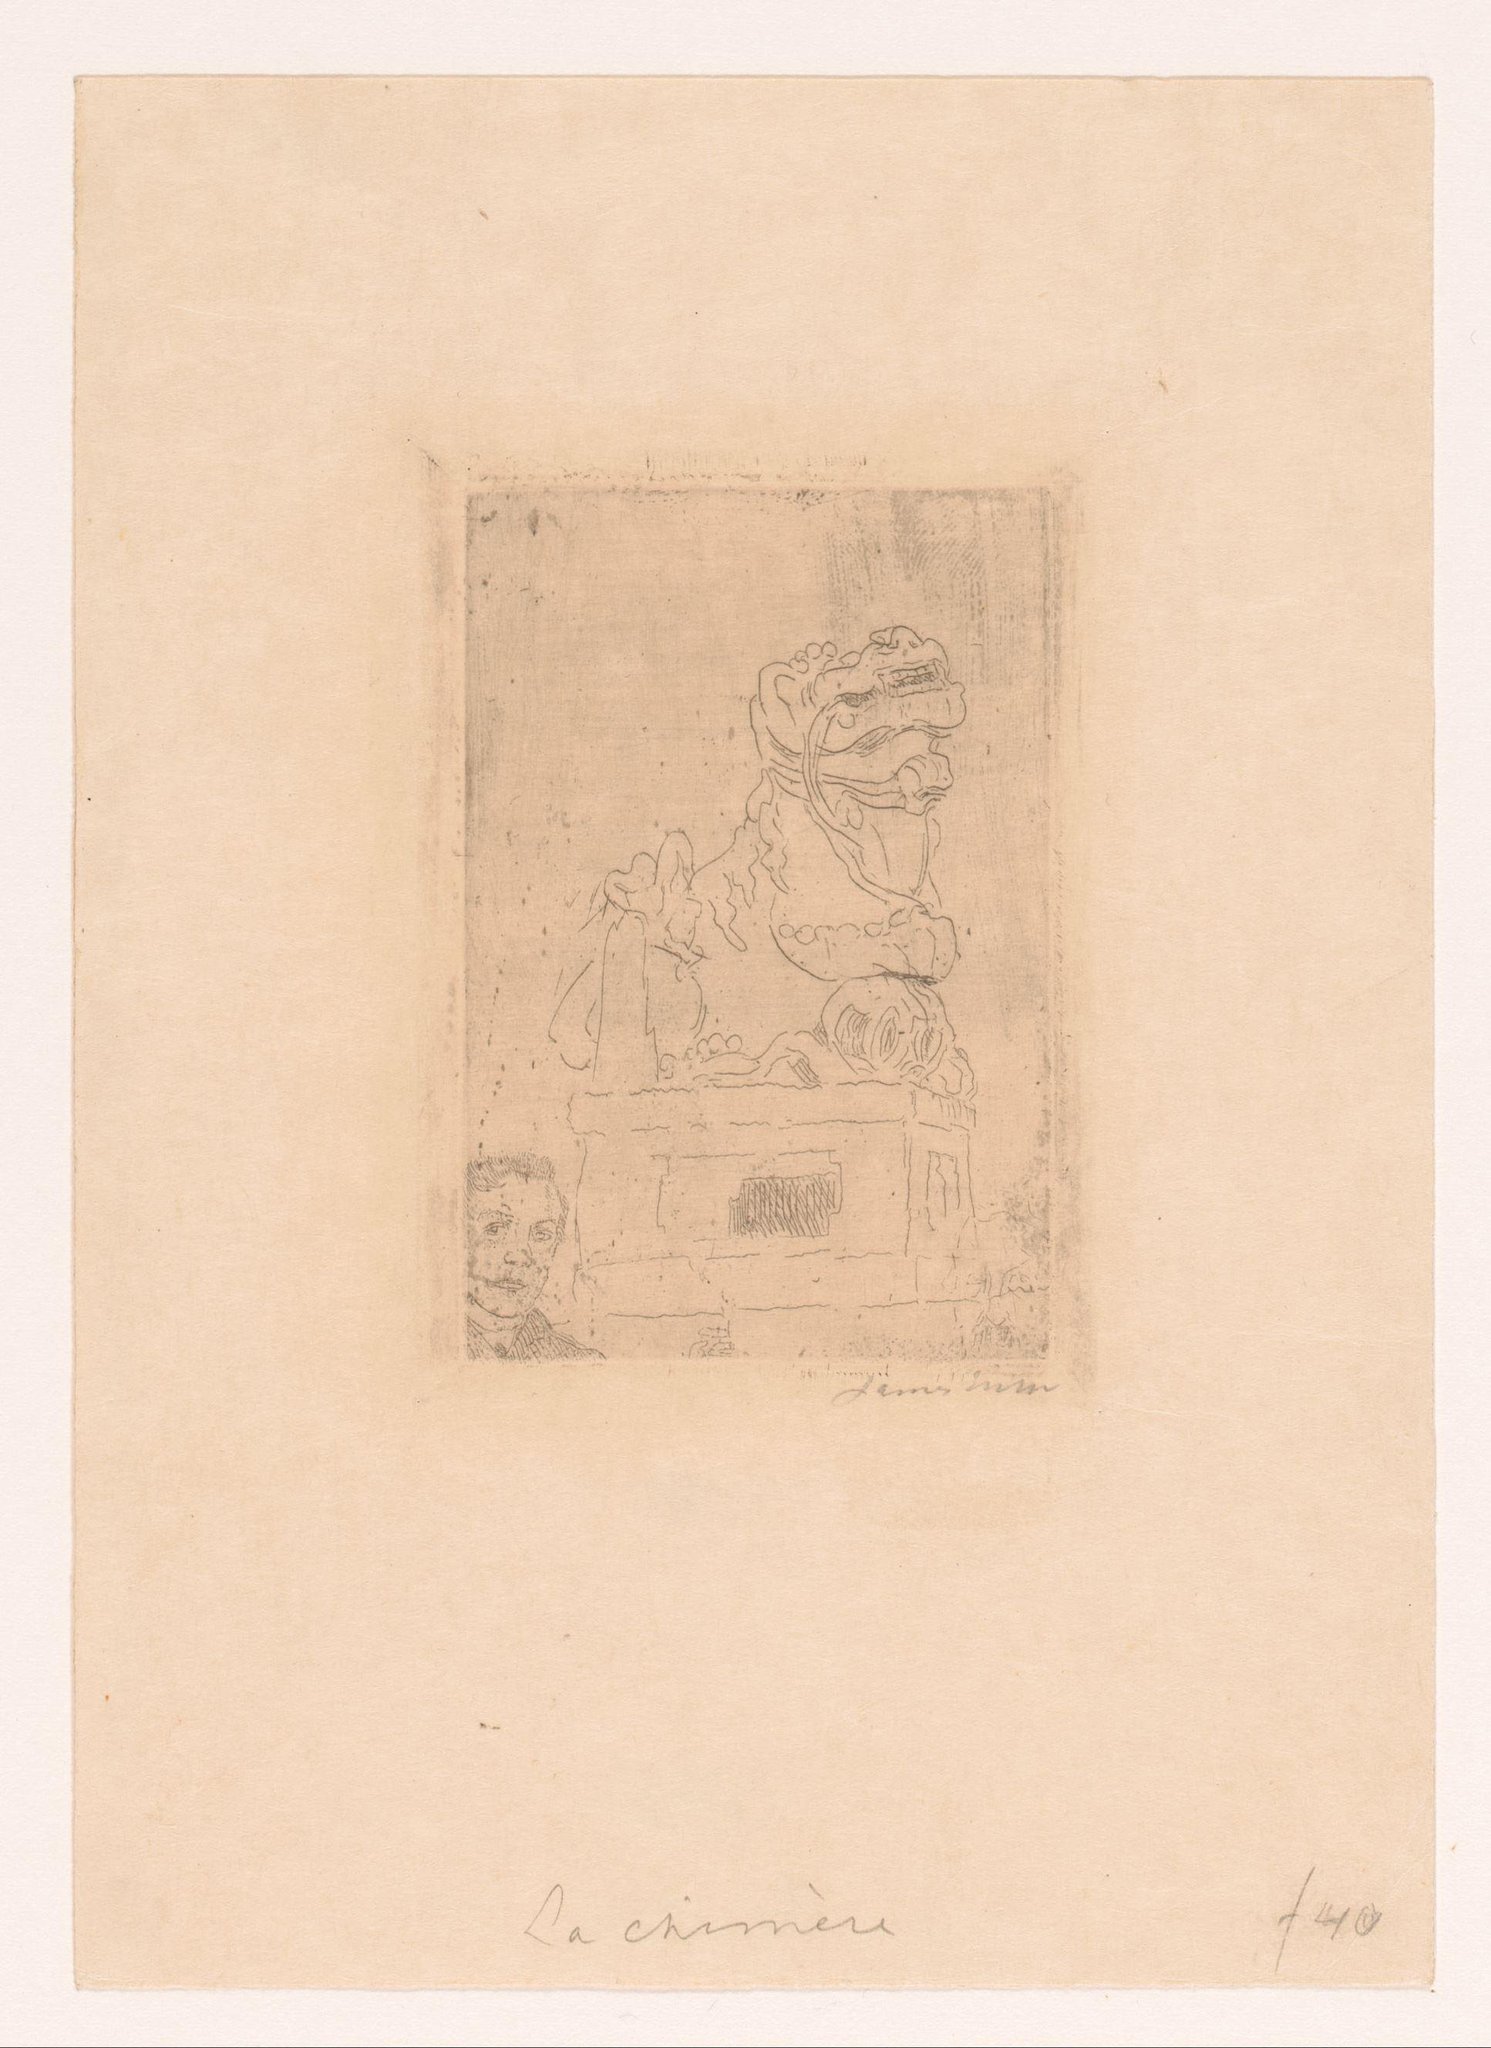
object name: print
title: Beeld van een chimeara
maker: james ensor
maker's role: print maker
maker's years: 1860-1949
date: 1888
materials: paper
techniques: etching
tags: piece of sculpture, reproduction of a piece of sculpture, chimera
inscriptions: collector's mark: Lugt 2760, collector's mark: Lugt 2228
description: De figuren links en rechts zijn mogelijk Ernest Rousseau en zijn zoon Ernest junior.